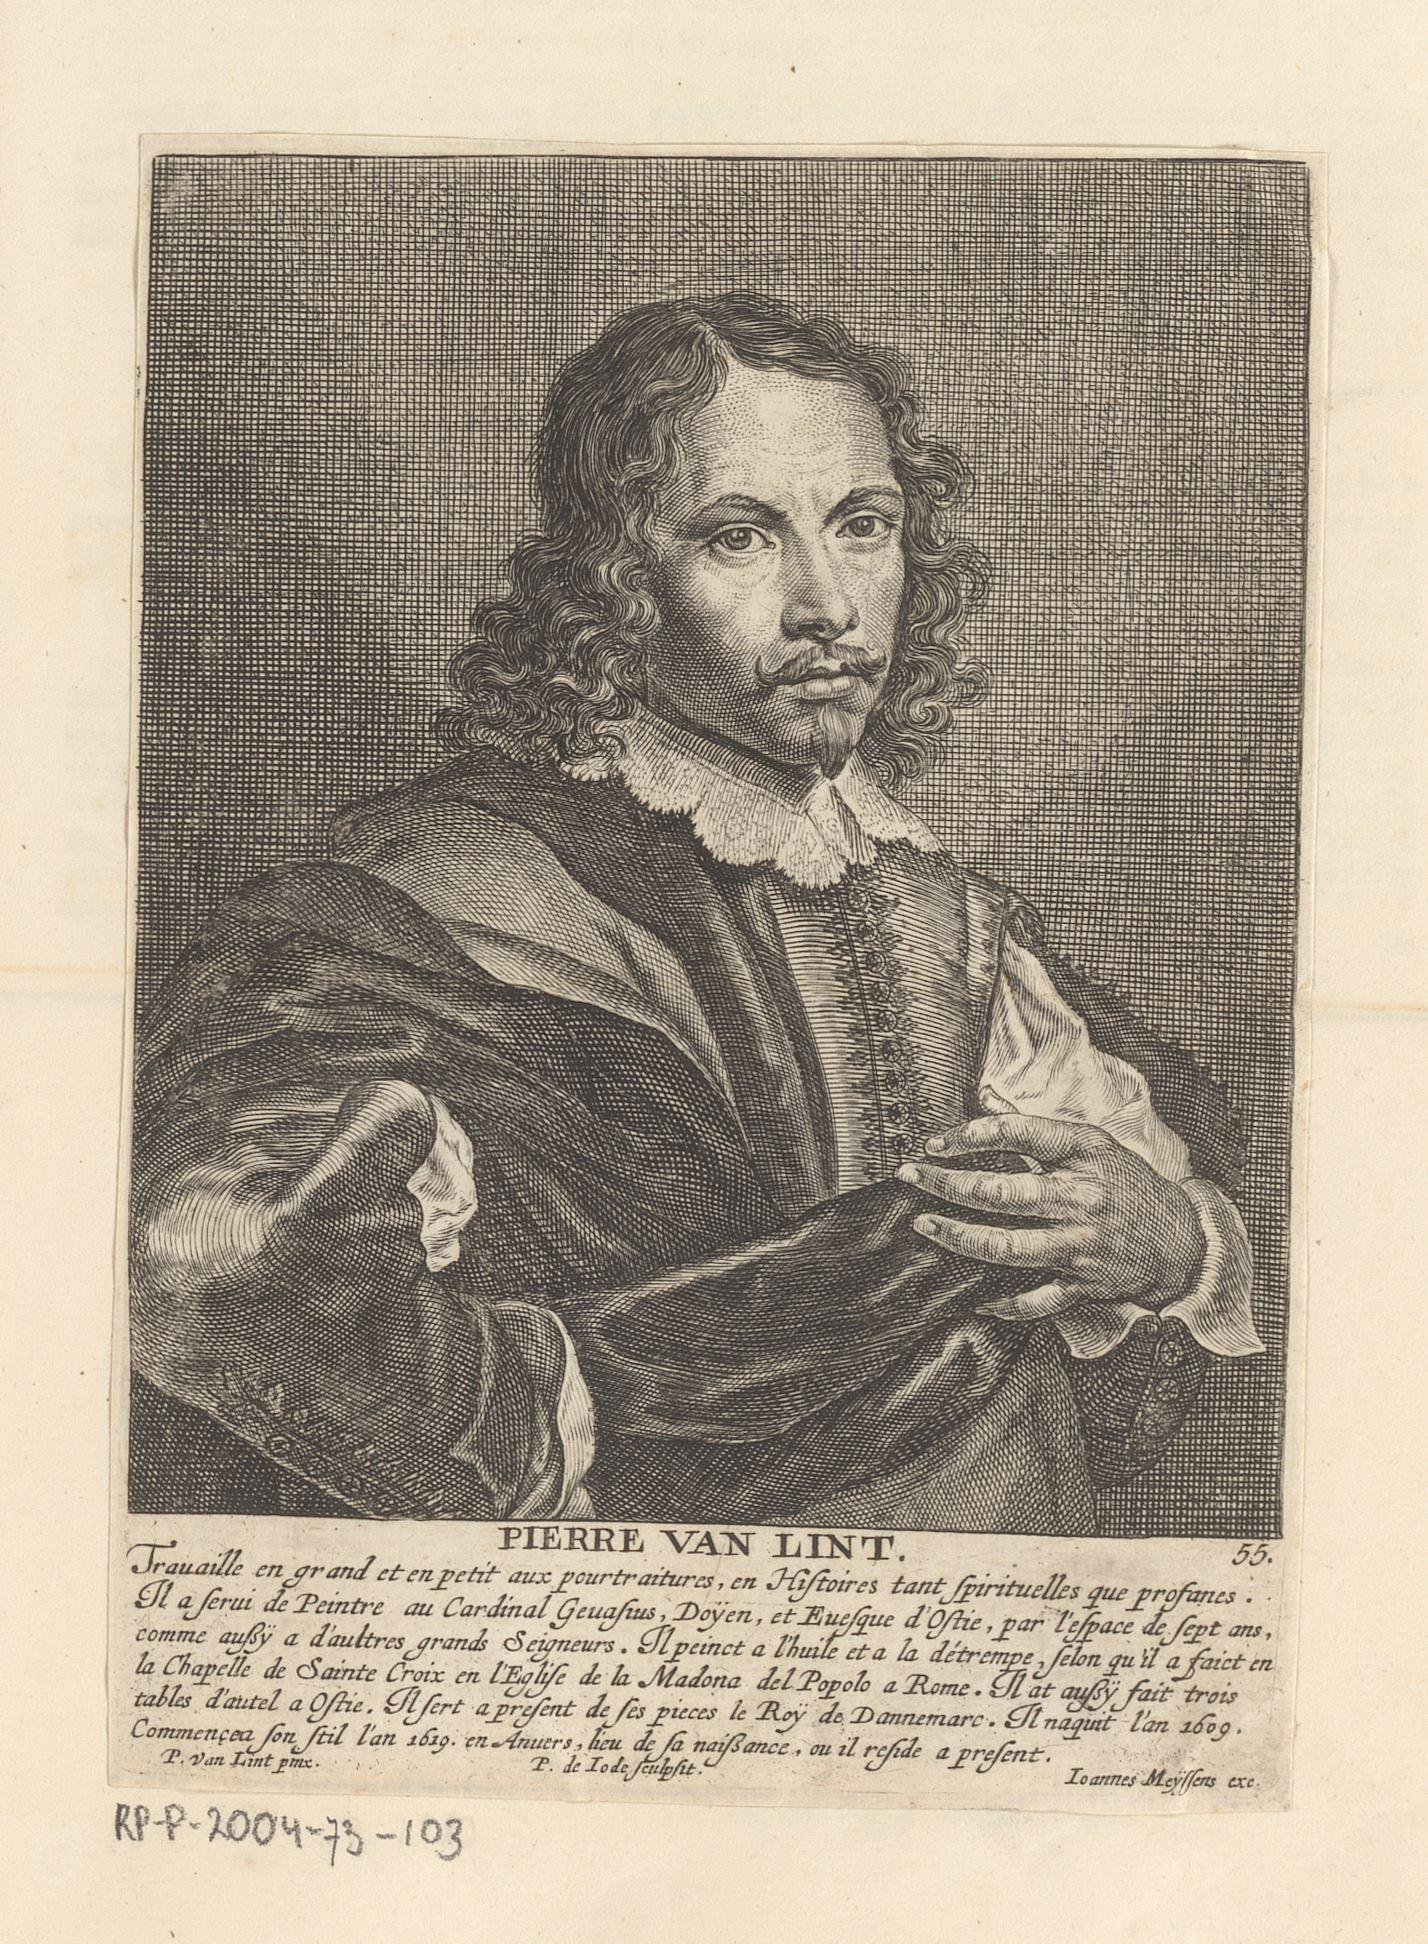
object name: print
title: Portret van Peter van Lint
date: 1649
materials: paper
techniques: engraving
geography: antwerp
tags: antwerp, painter, print maker, draughtsman, peter van lint, historical persons, portrait, self-portrait of painter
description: Prent mogelijk uit: Meyssens, Joannes. Image de divers hommes desprit sublime qui par leur art et science deburovent vivre eternellement et des quels la louange et renommée faict estonner le monde. 2 dln. Antwerpen: Joannes Meyssens, 1649, dl. 1, p. 12. Andere staat van prent gebruikt in: Bie, Cornelis De. Het gulden Cabinet vande edel vry schilder const, inhoudende den lof vande vermarste schilders, architecte, beldthowers ende plaetsnyders van dese eeuw. Antwerpen: Joannes Meyssens, 1662 [1661 foutief op titelpagina]. De samensteller heeft deze prent in het album geplakt als illustratie bij: Pilkington, Matthew en Johann Heinrich Füssli. A dictionary of painters, from the revival of the art to the present period. 4 dln. Londen: John Crowder, 1805, dl. 2, p. 297.